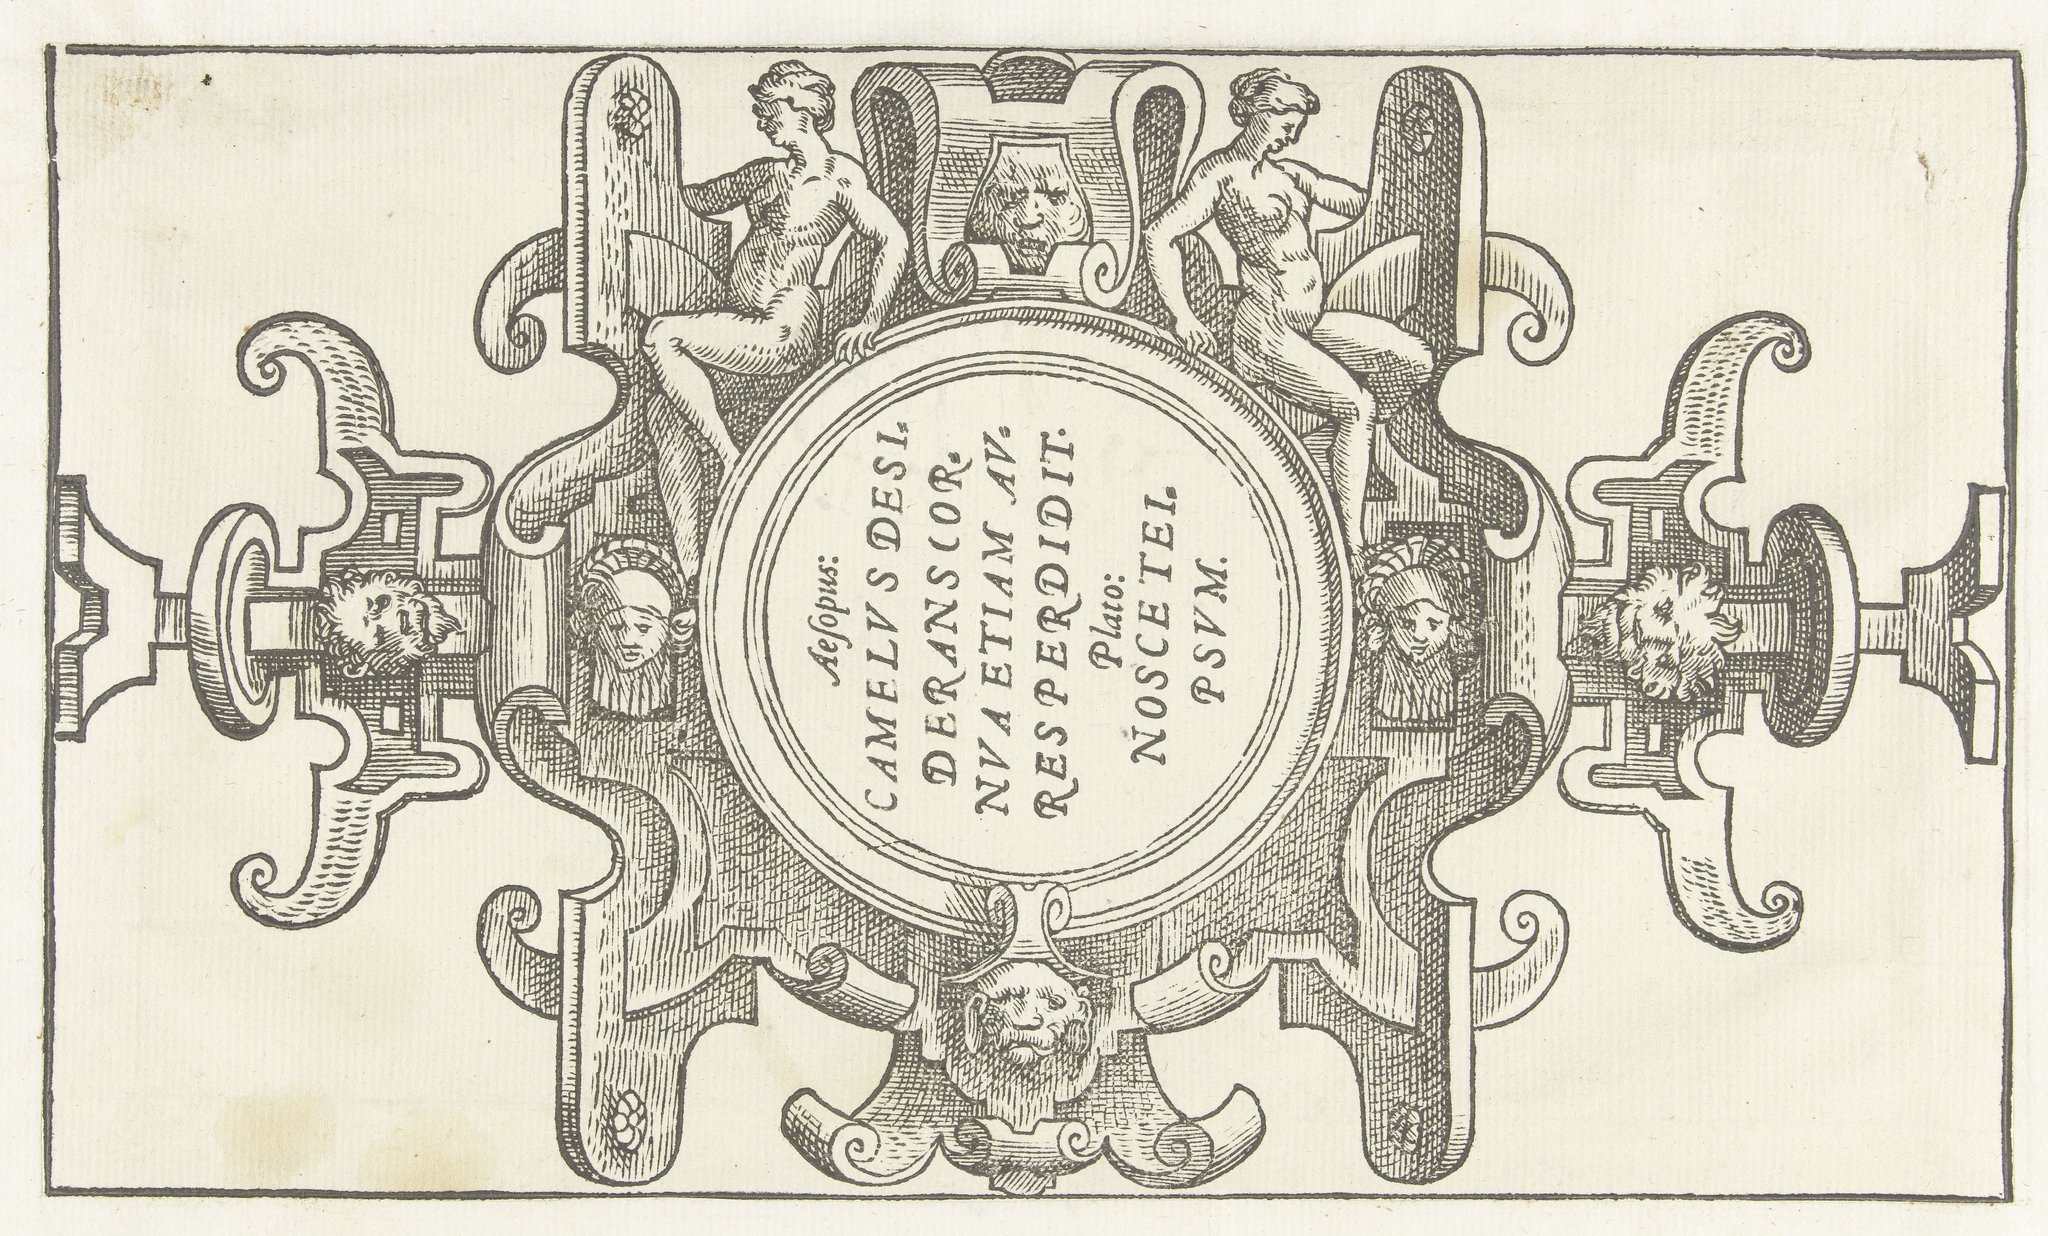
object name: ornament print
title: Titel en 15 bladen van de reeks: Varii generis partitionum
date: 1556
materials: paper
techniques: woodcut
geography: netherlands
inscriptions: number: ‘106’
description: De cartouche is dwars in de omlijsting van rolwerk geplaatst. Op de omlijsting zitten bovenaan twee naakte vrouwen. Blad hoort bij 15 bladen met titelblad afkomstig uit een serie van 24 bladen. Houtsneden.